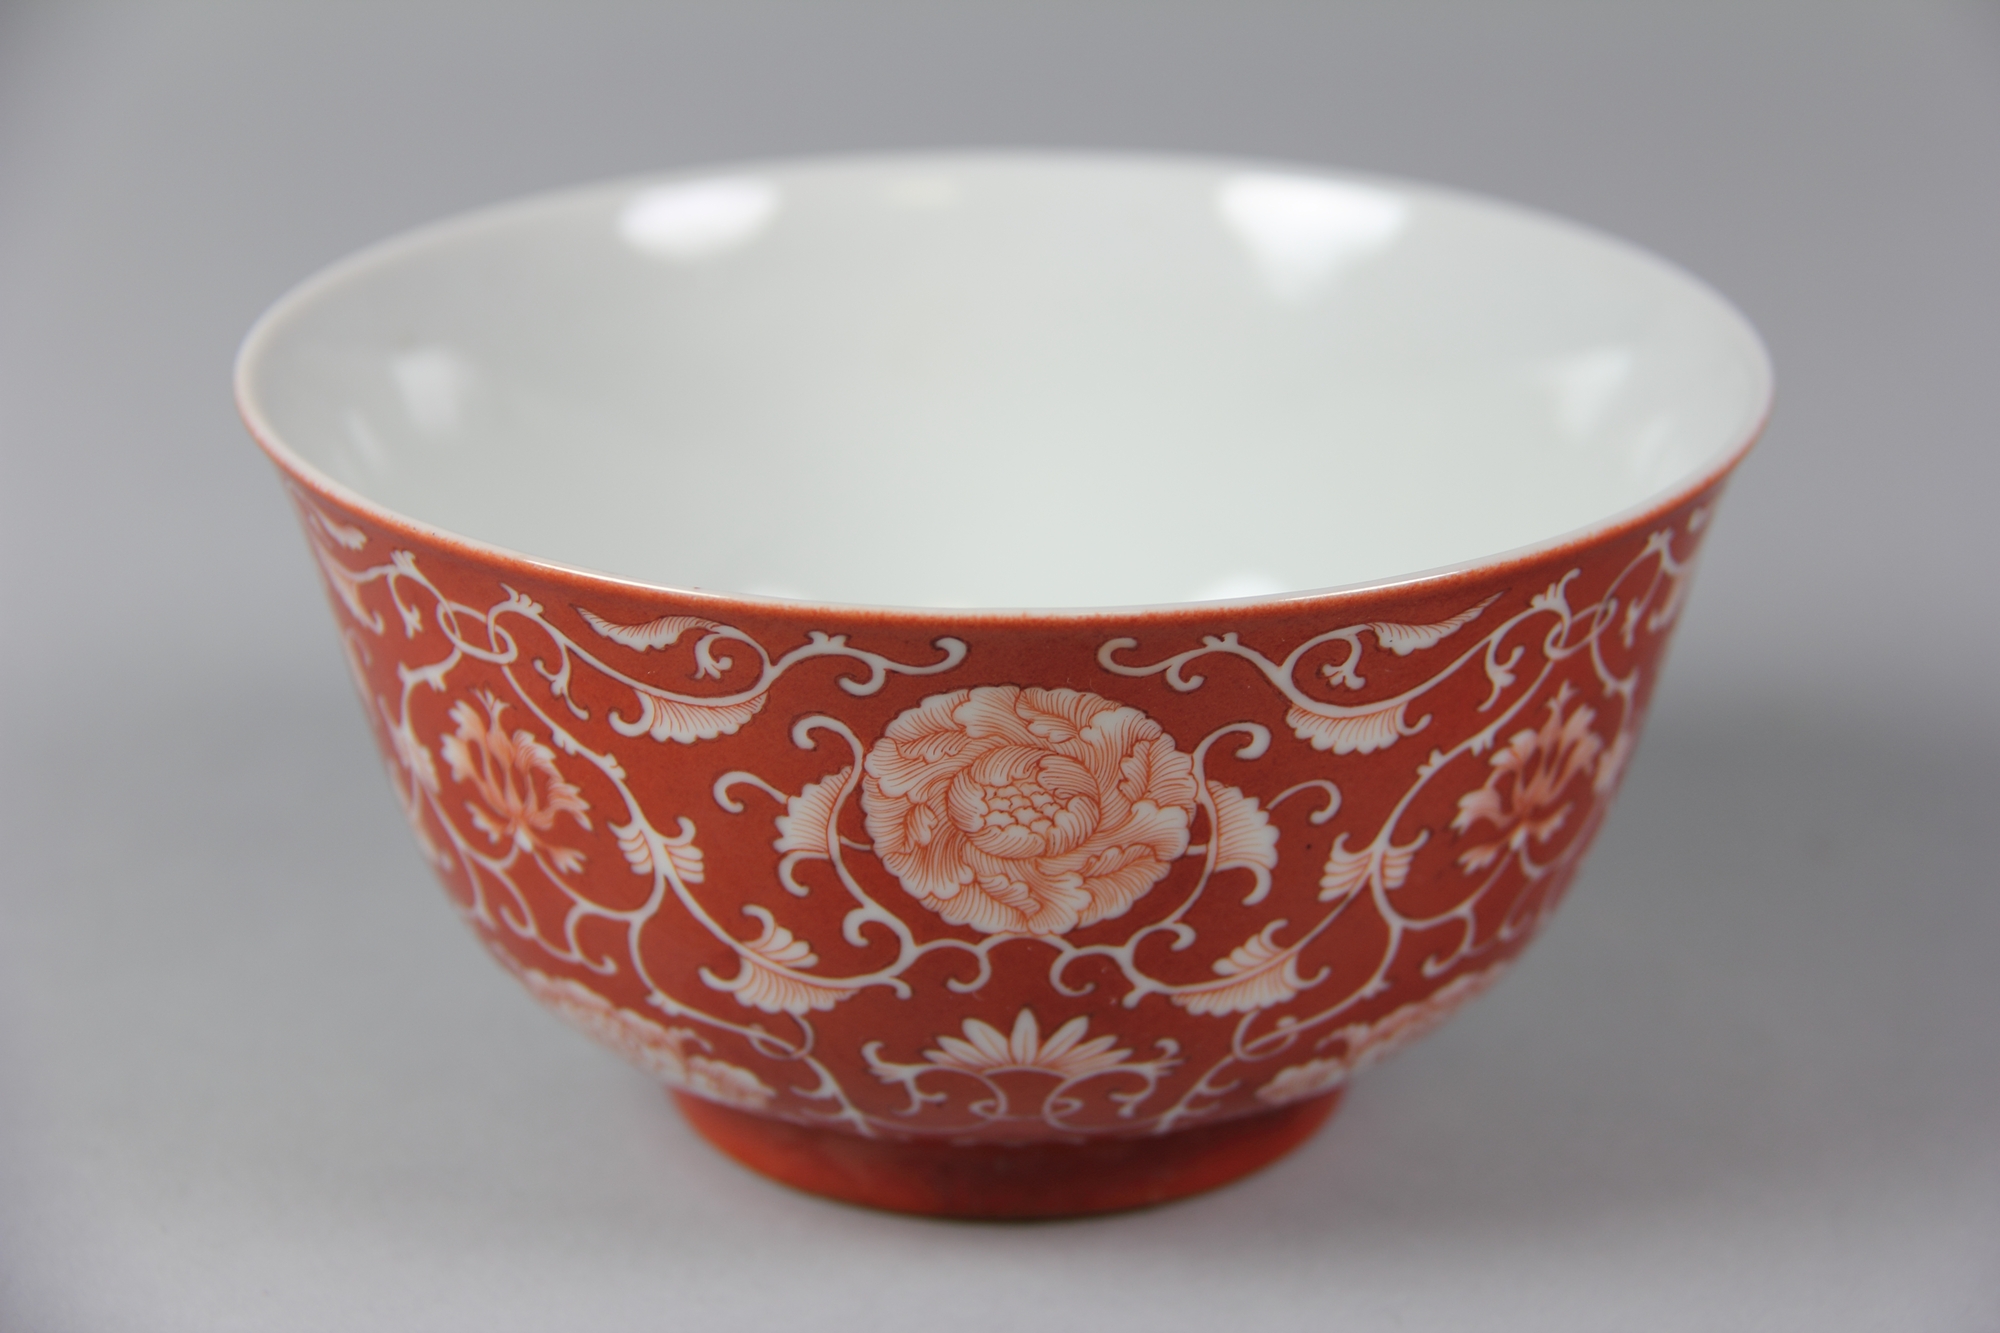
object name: bowl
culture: chinese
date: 1821-1850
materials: enamel, porcelain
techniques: overglaze, painting